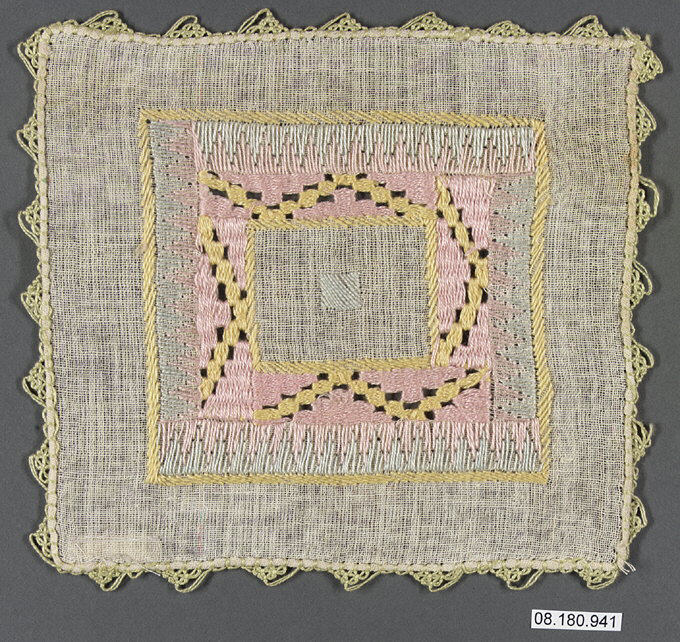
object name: square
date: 1801-1900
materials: cotton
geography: israel